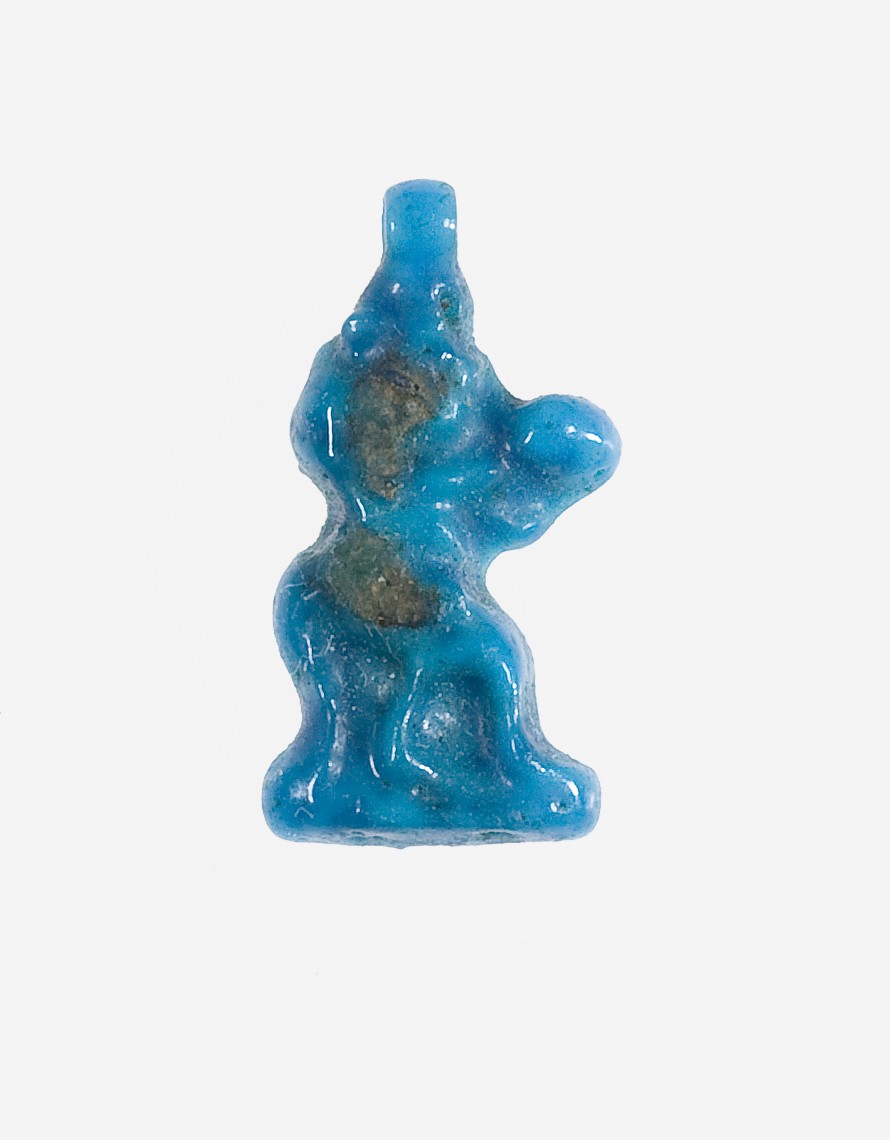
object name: pendant, be, tambourine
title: Amulet of Bes with tambourine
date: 1390-1352 BCE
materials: faience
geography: egypt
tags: bes